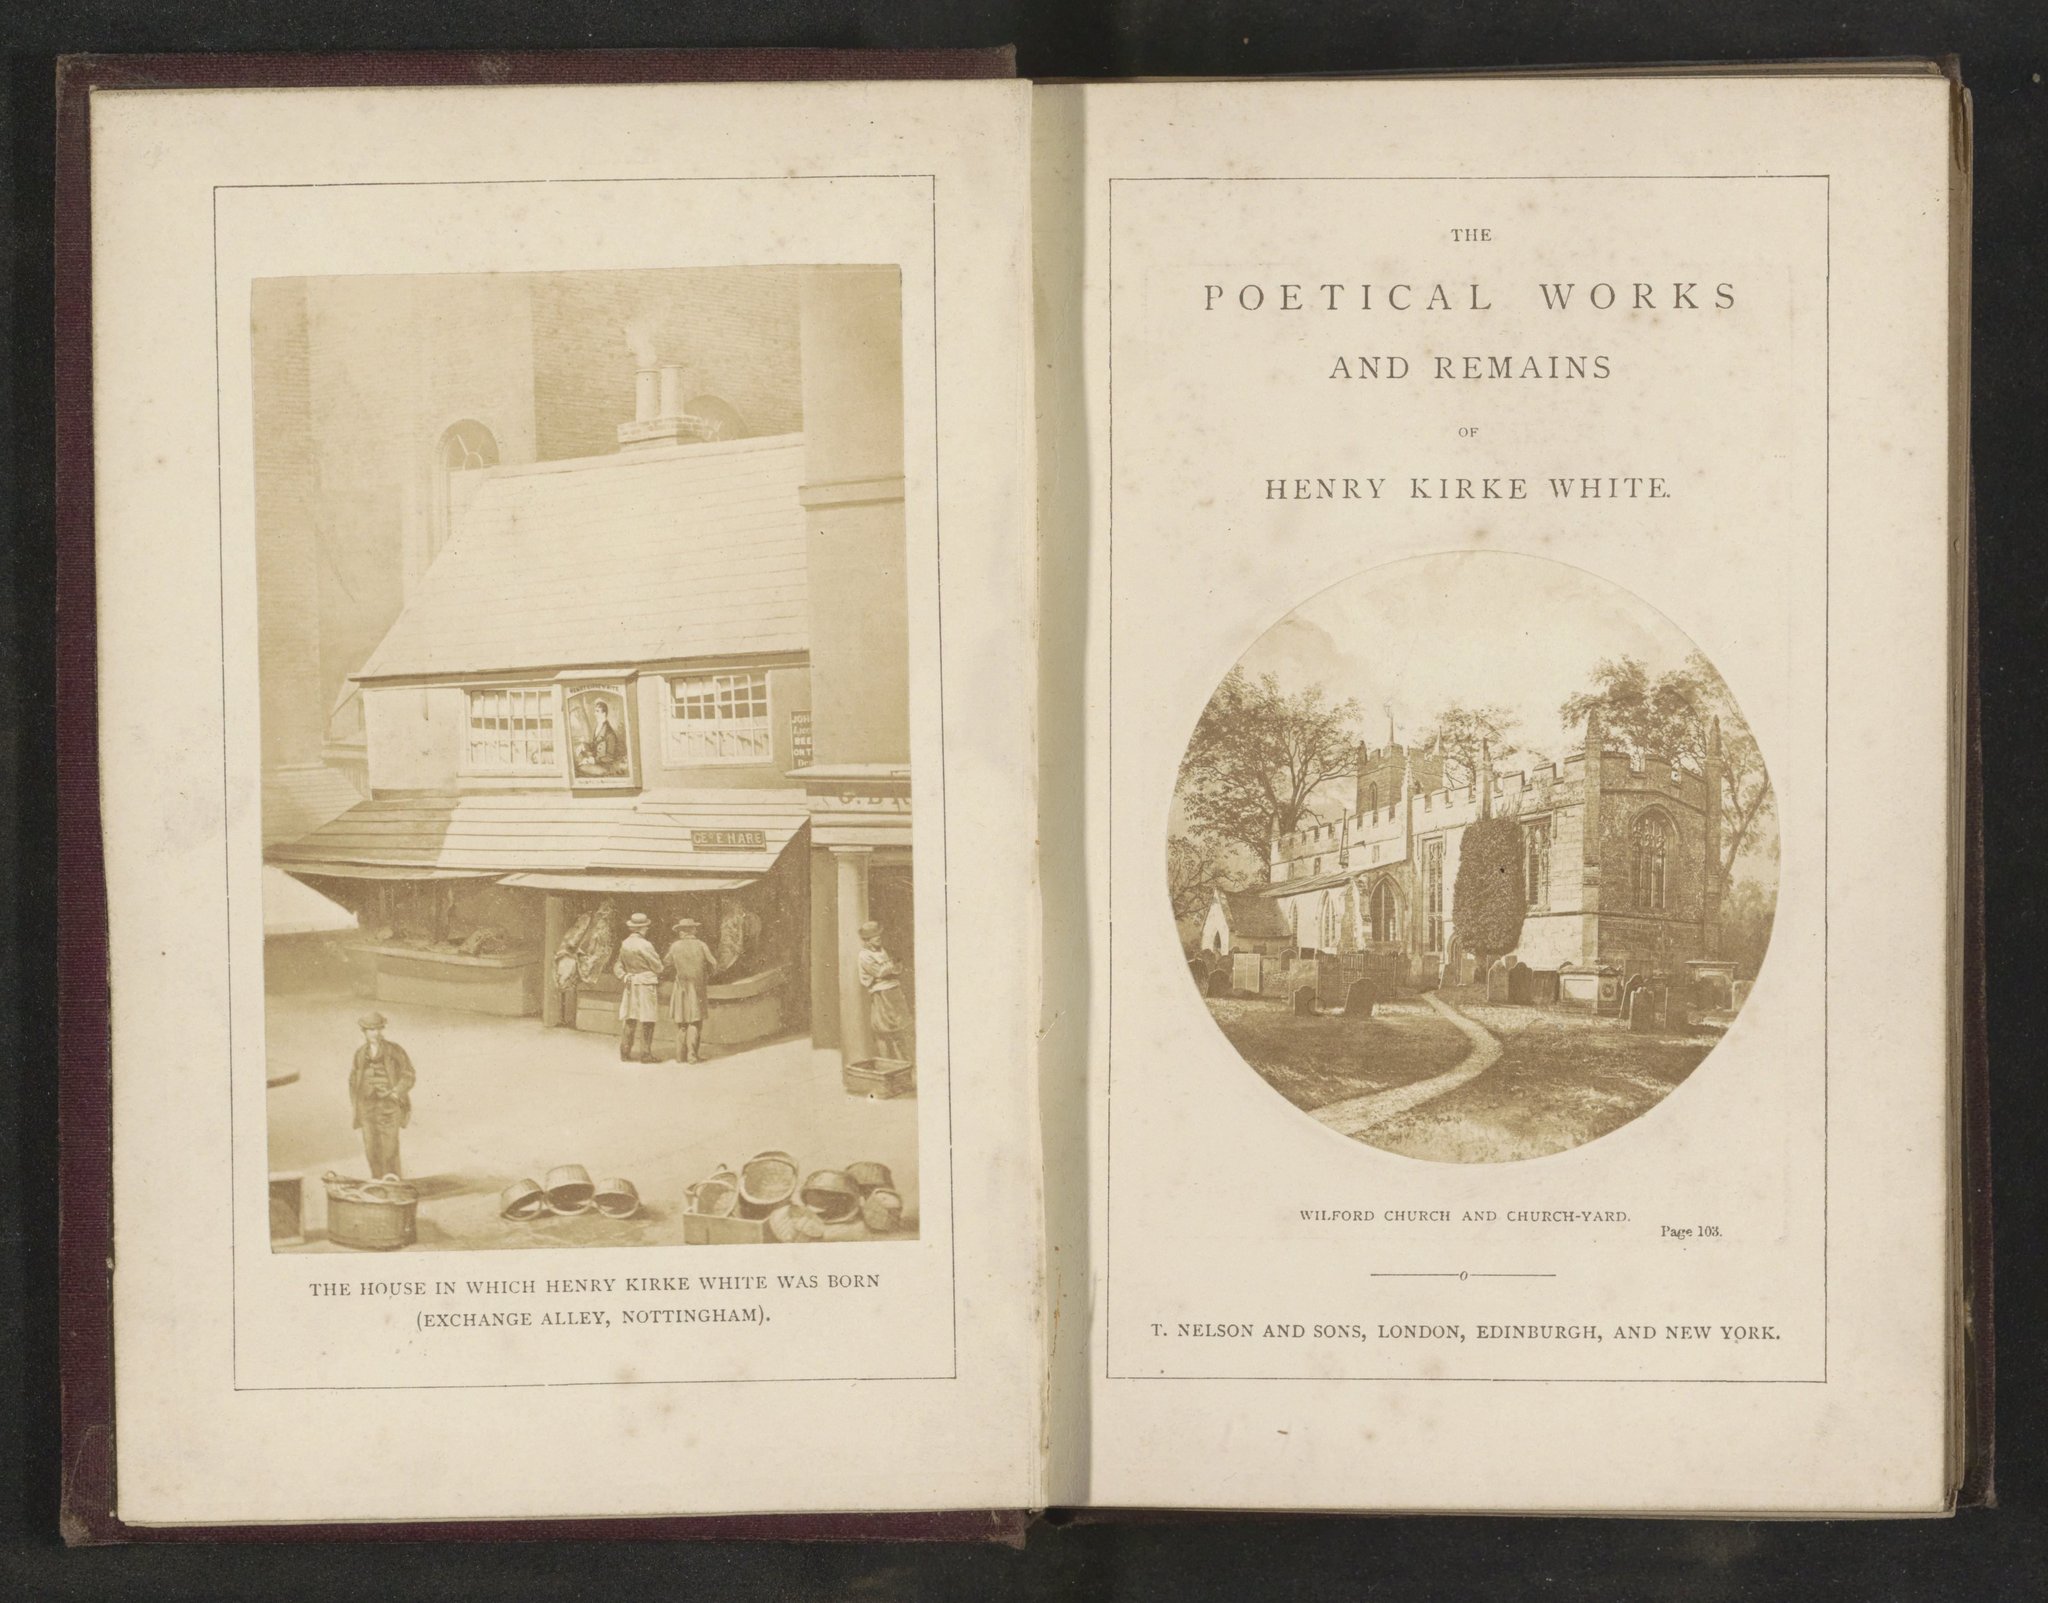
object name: page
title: The house in which Henry Kirke White was born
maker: Anonymous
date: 1855-1865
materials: photographic support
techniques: albumen print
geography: nottingham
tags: housing, façade (of house or building)